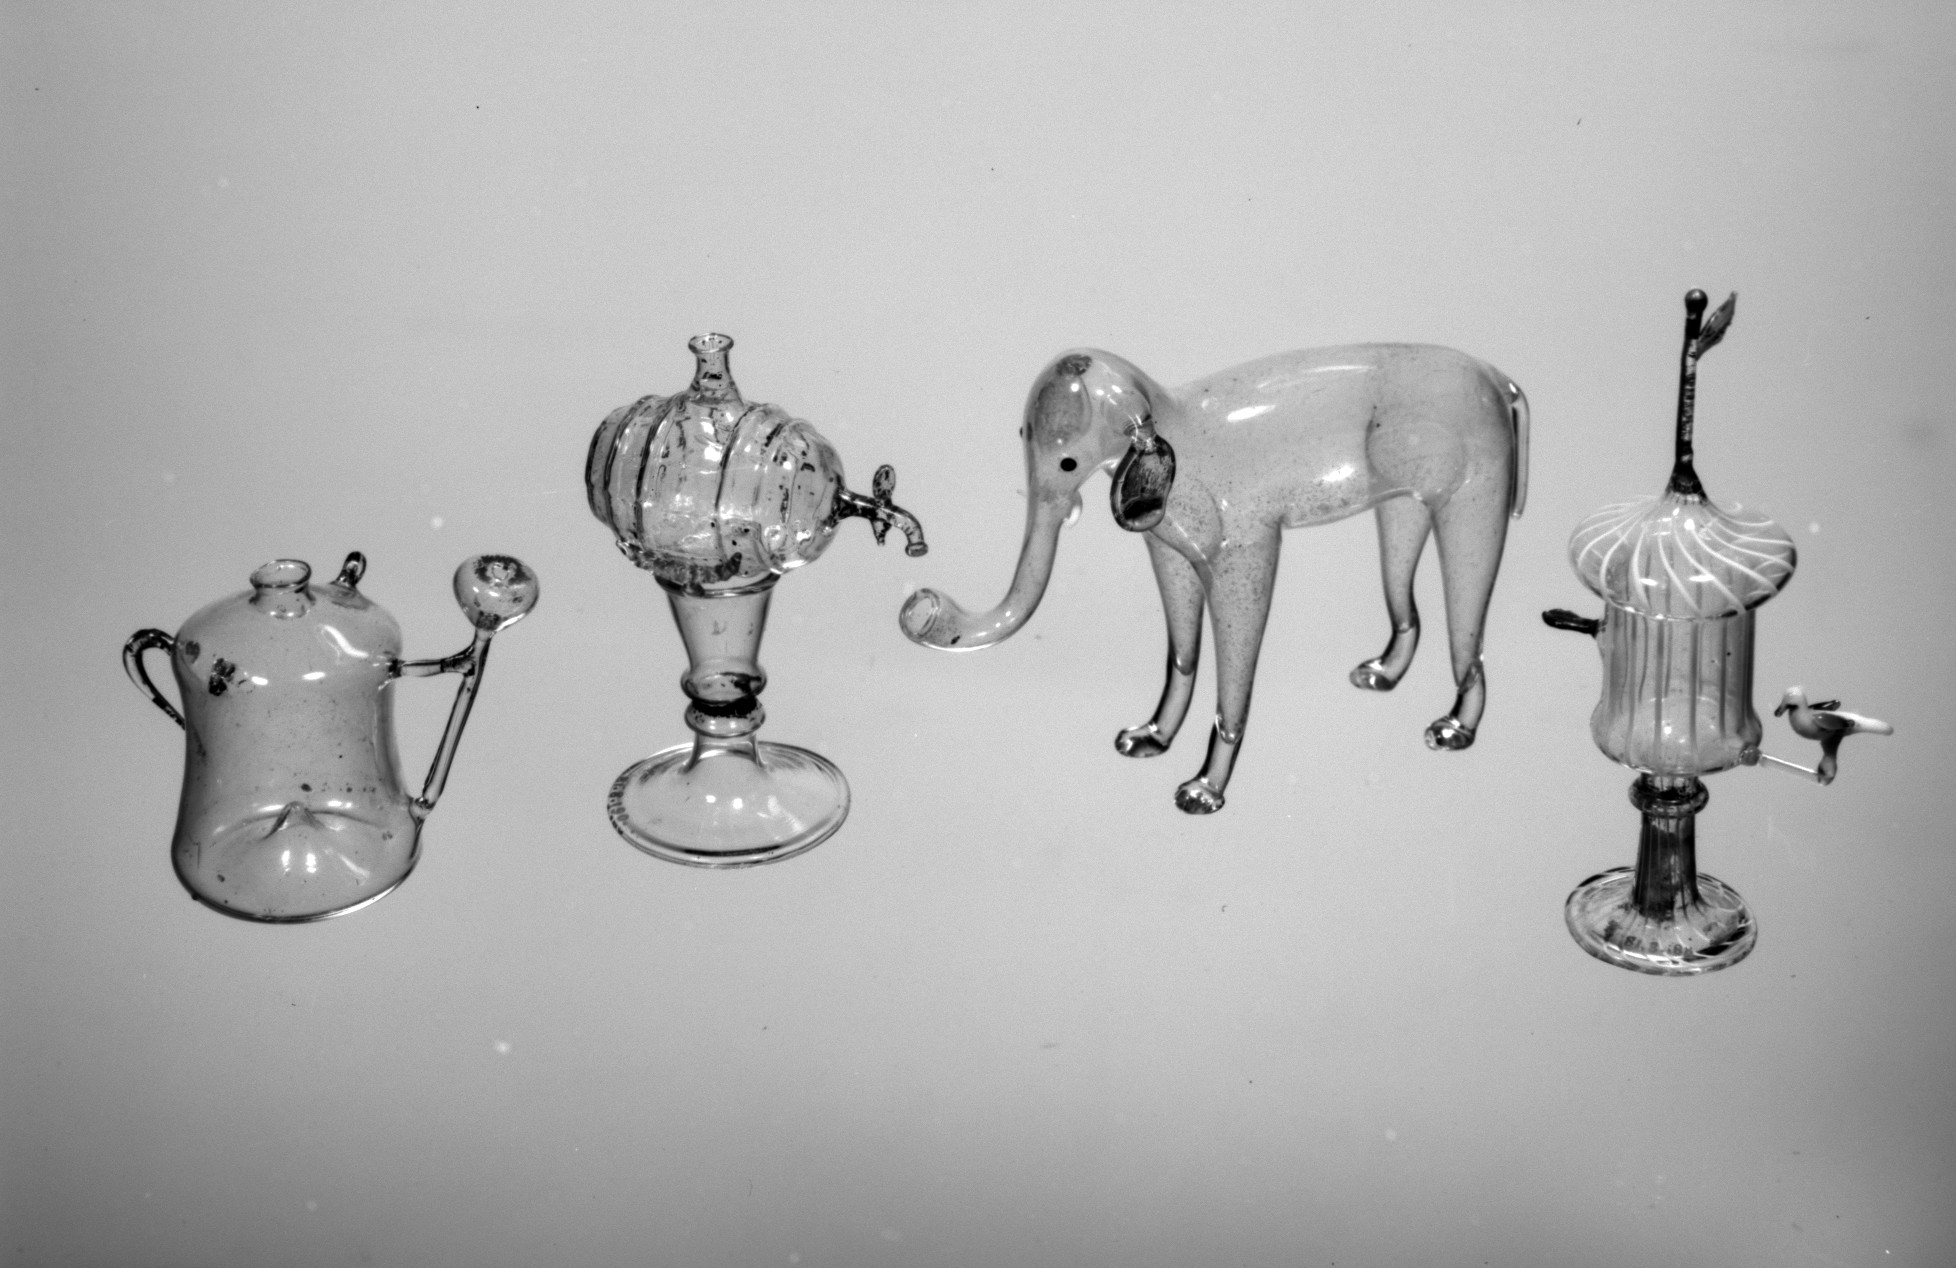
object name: watering can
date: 1801-1900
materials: glass